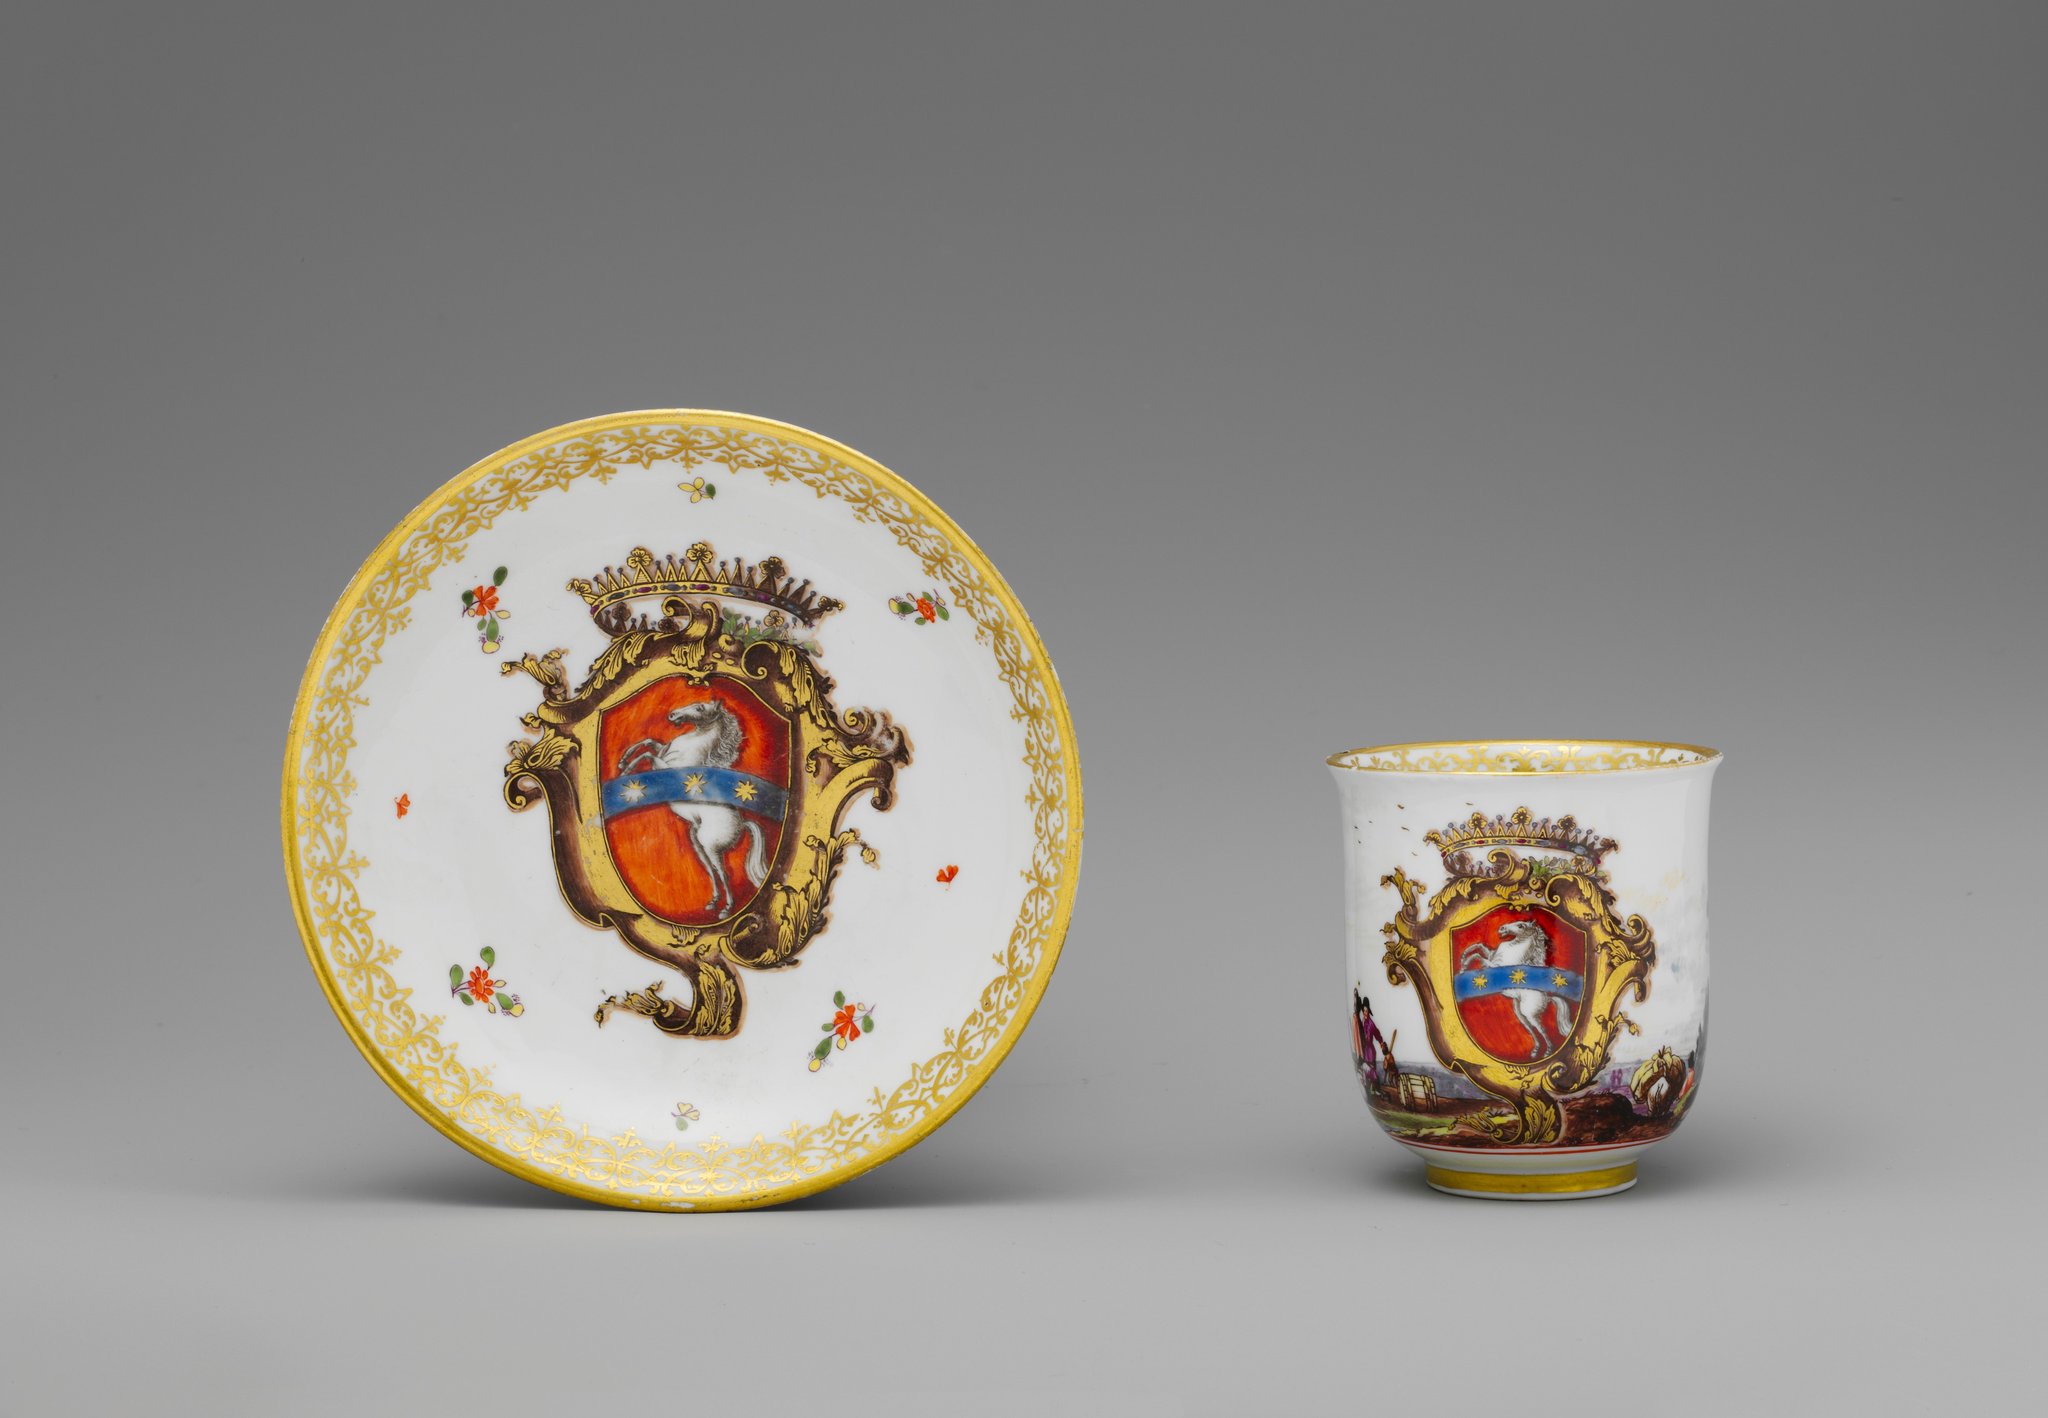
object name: cup and saucer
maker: meissen manufactory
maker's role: manufactory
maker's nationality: german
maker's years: 1710-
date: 1735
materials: hard paste porcelain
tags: men,coat of arms,boats